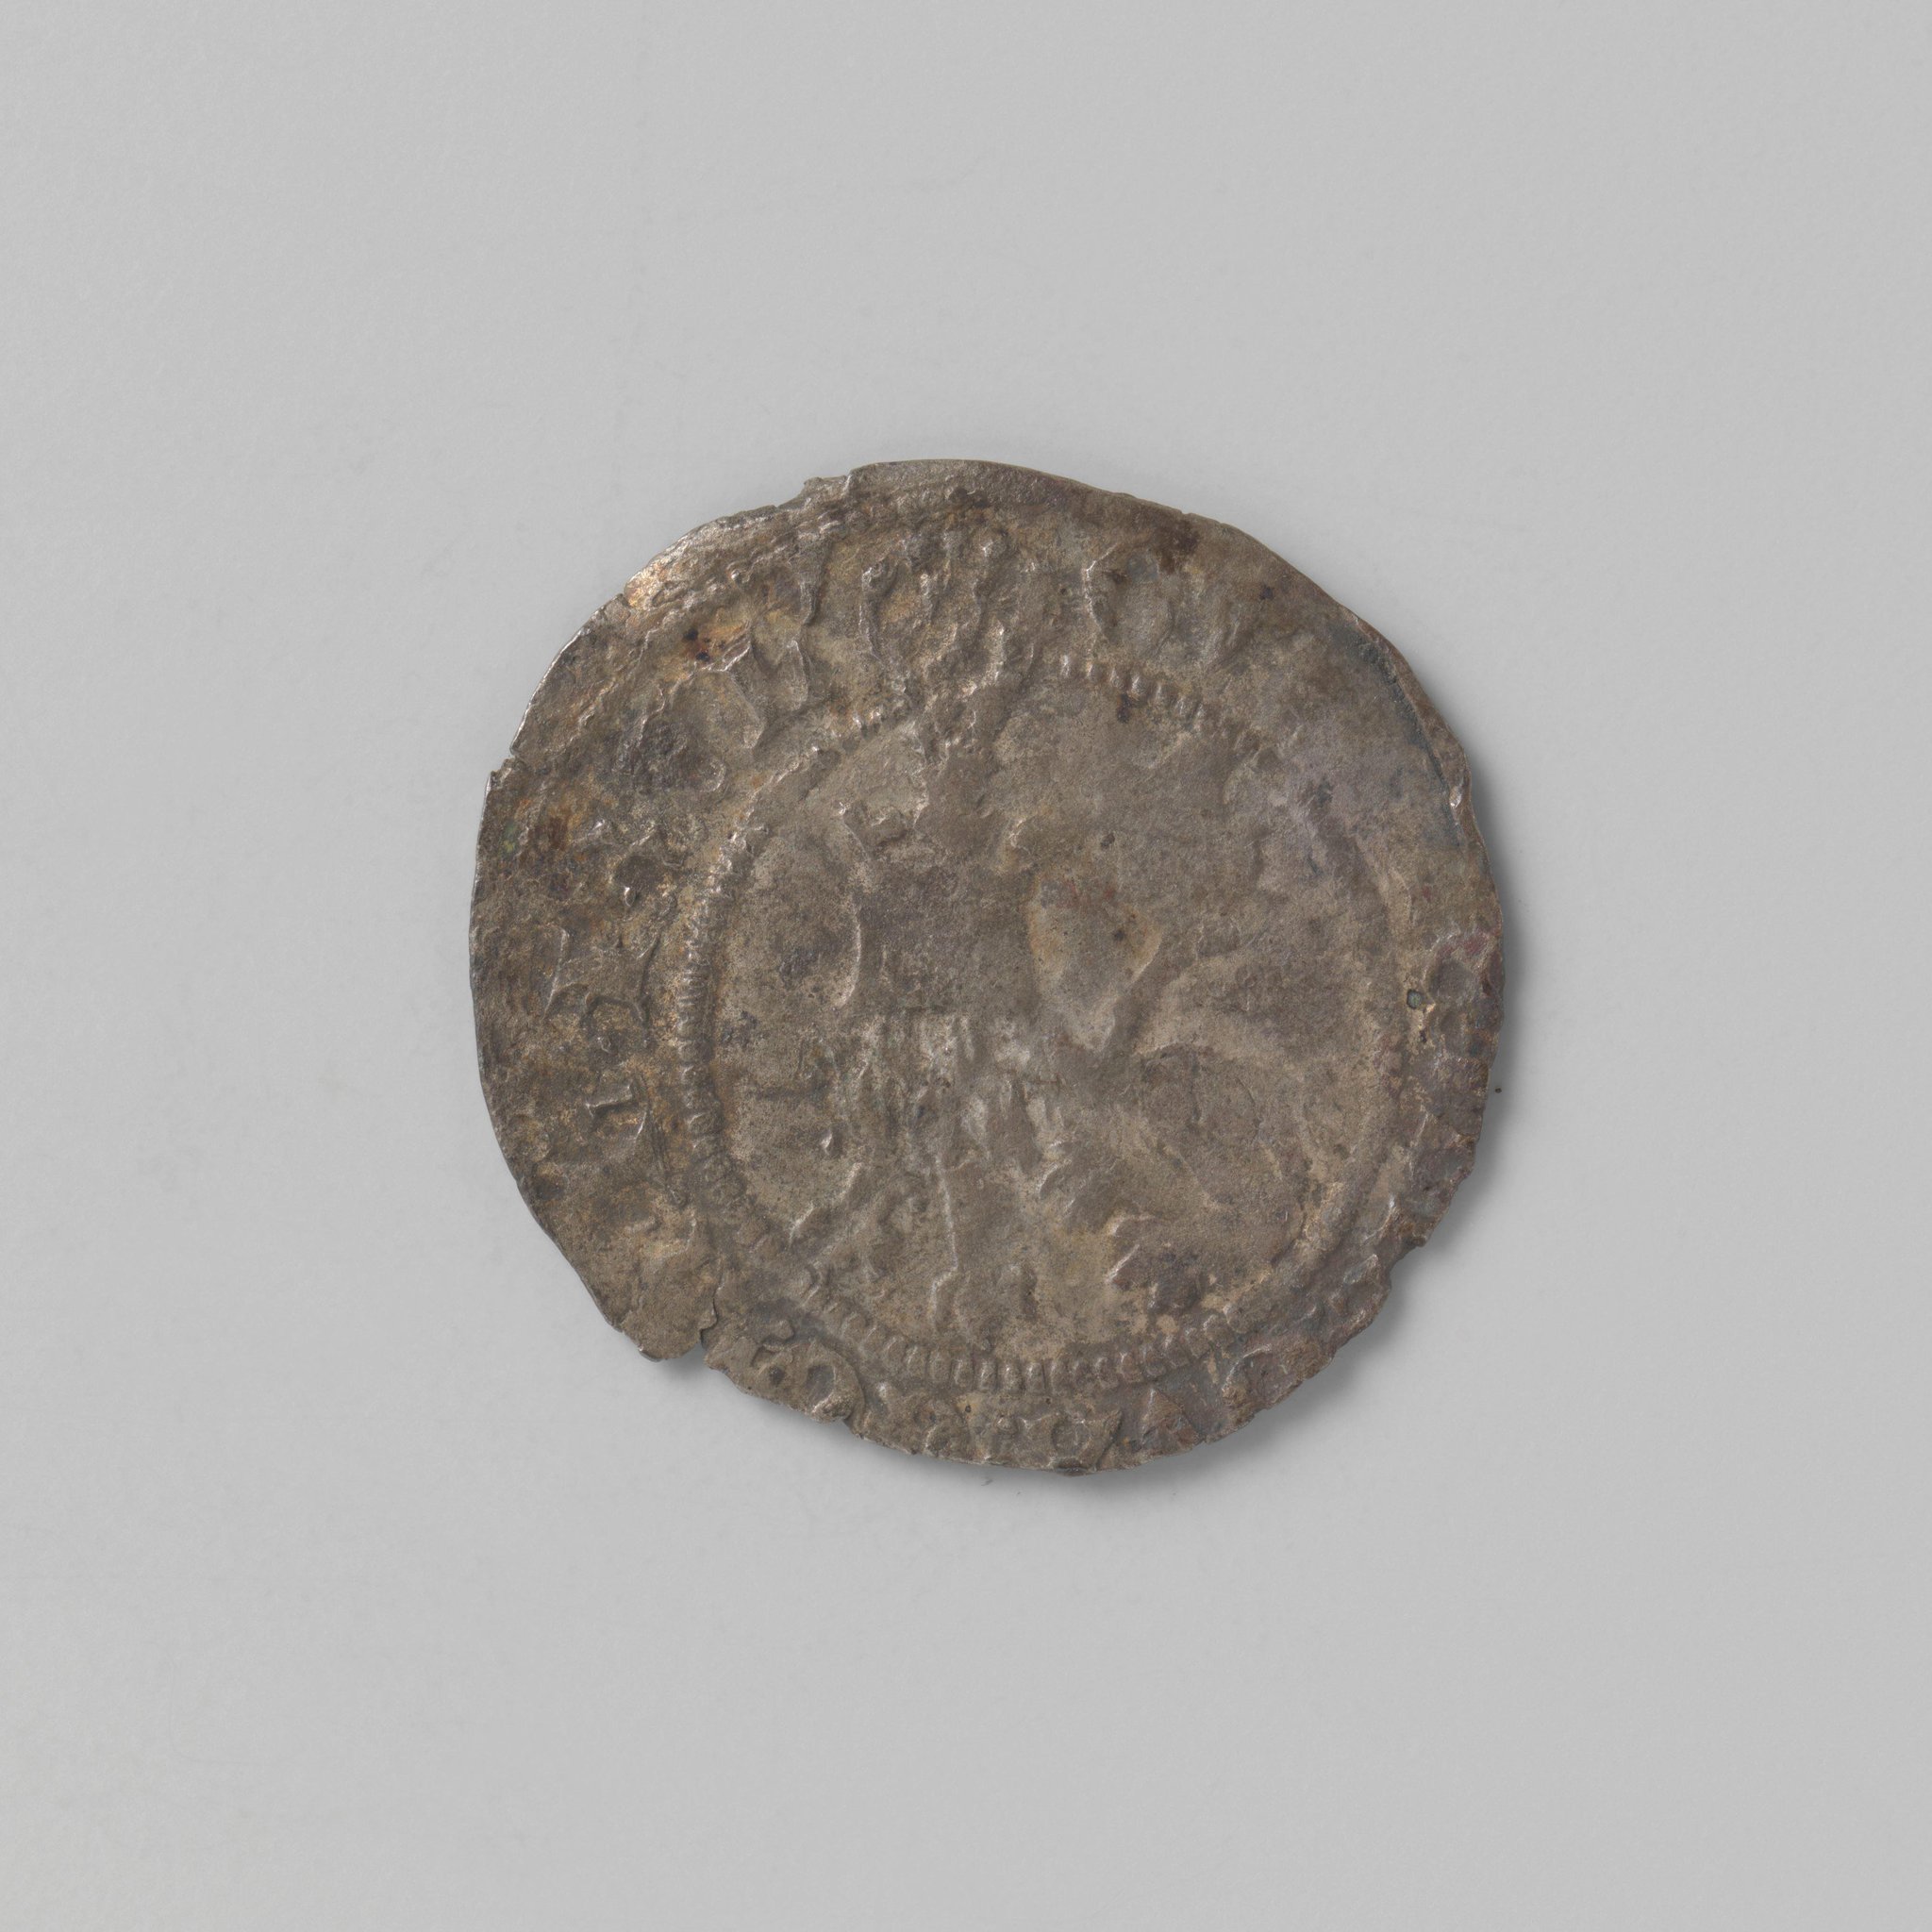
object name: coin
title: Hollandse kwart plak van Willem V, 1345-1389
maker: willem v van holland (graaf van holland en zeeland)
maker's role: earl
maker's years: 1330-1389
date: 1376-1378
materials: silver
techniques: striking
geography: dordrecht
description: Zilveren munt. Voorzijde: binnen veelpas zittende leeuw naar links met helm en helmteken. Keerzijde: lang gevoet kruis met in hoeken letters H,L,A en D